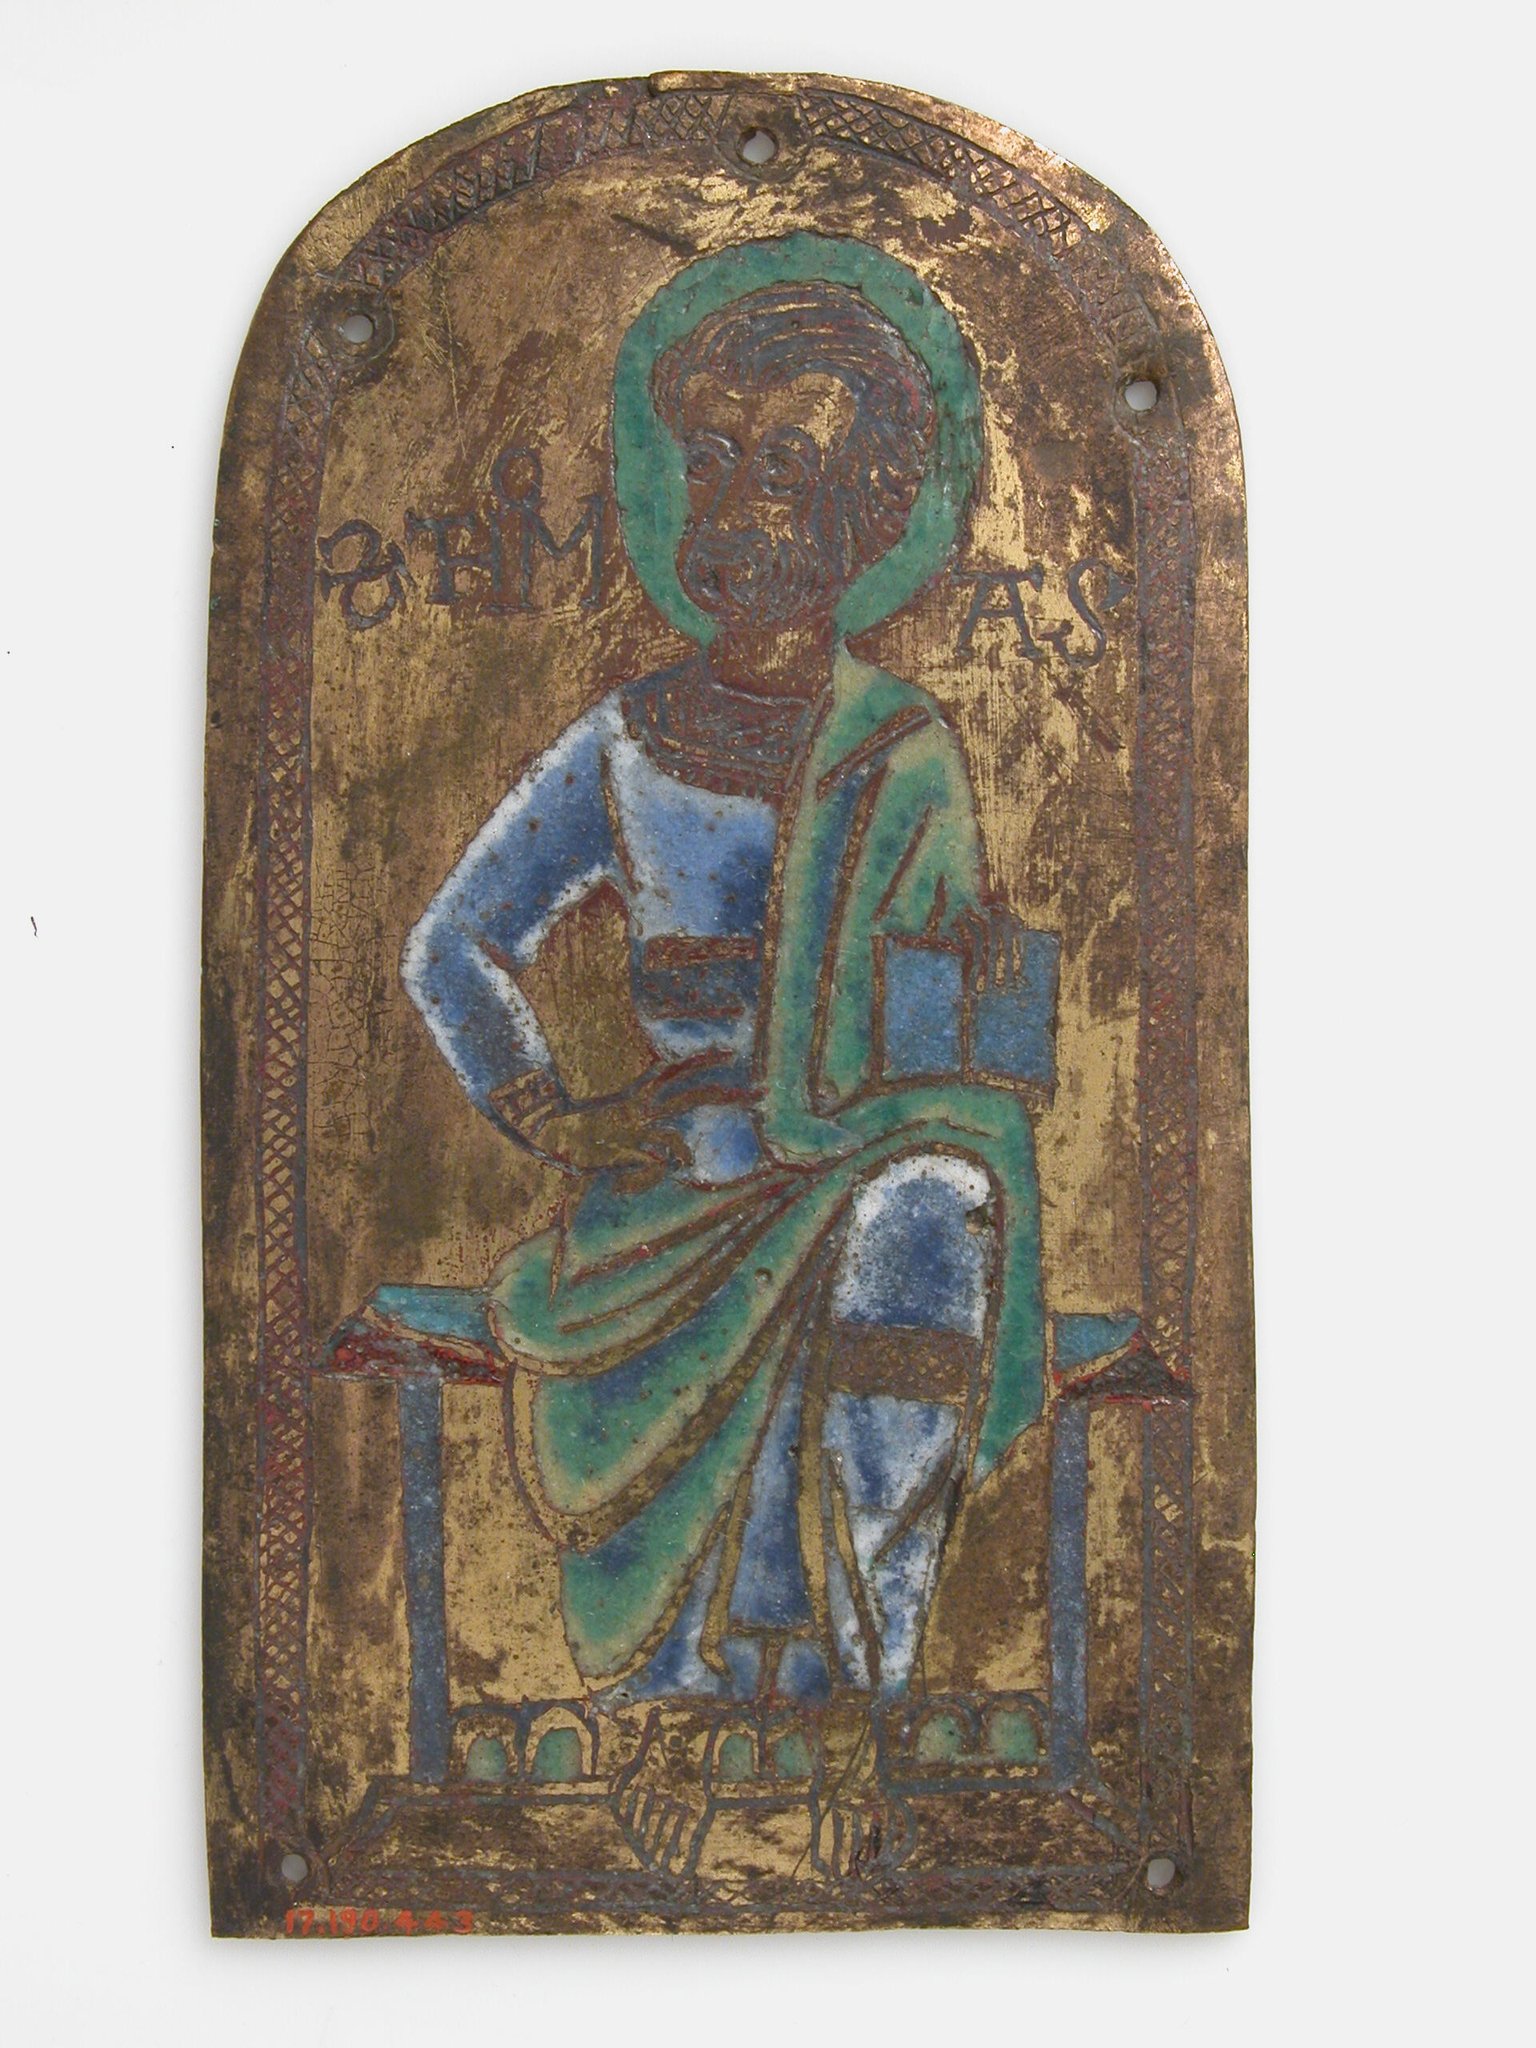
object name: plaque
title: Plaque of St. Thomas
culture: rhenish or saxon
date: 1134-1166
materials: gilt copper, enamel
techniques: enamel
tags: men